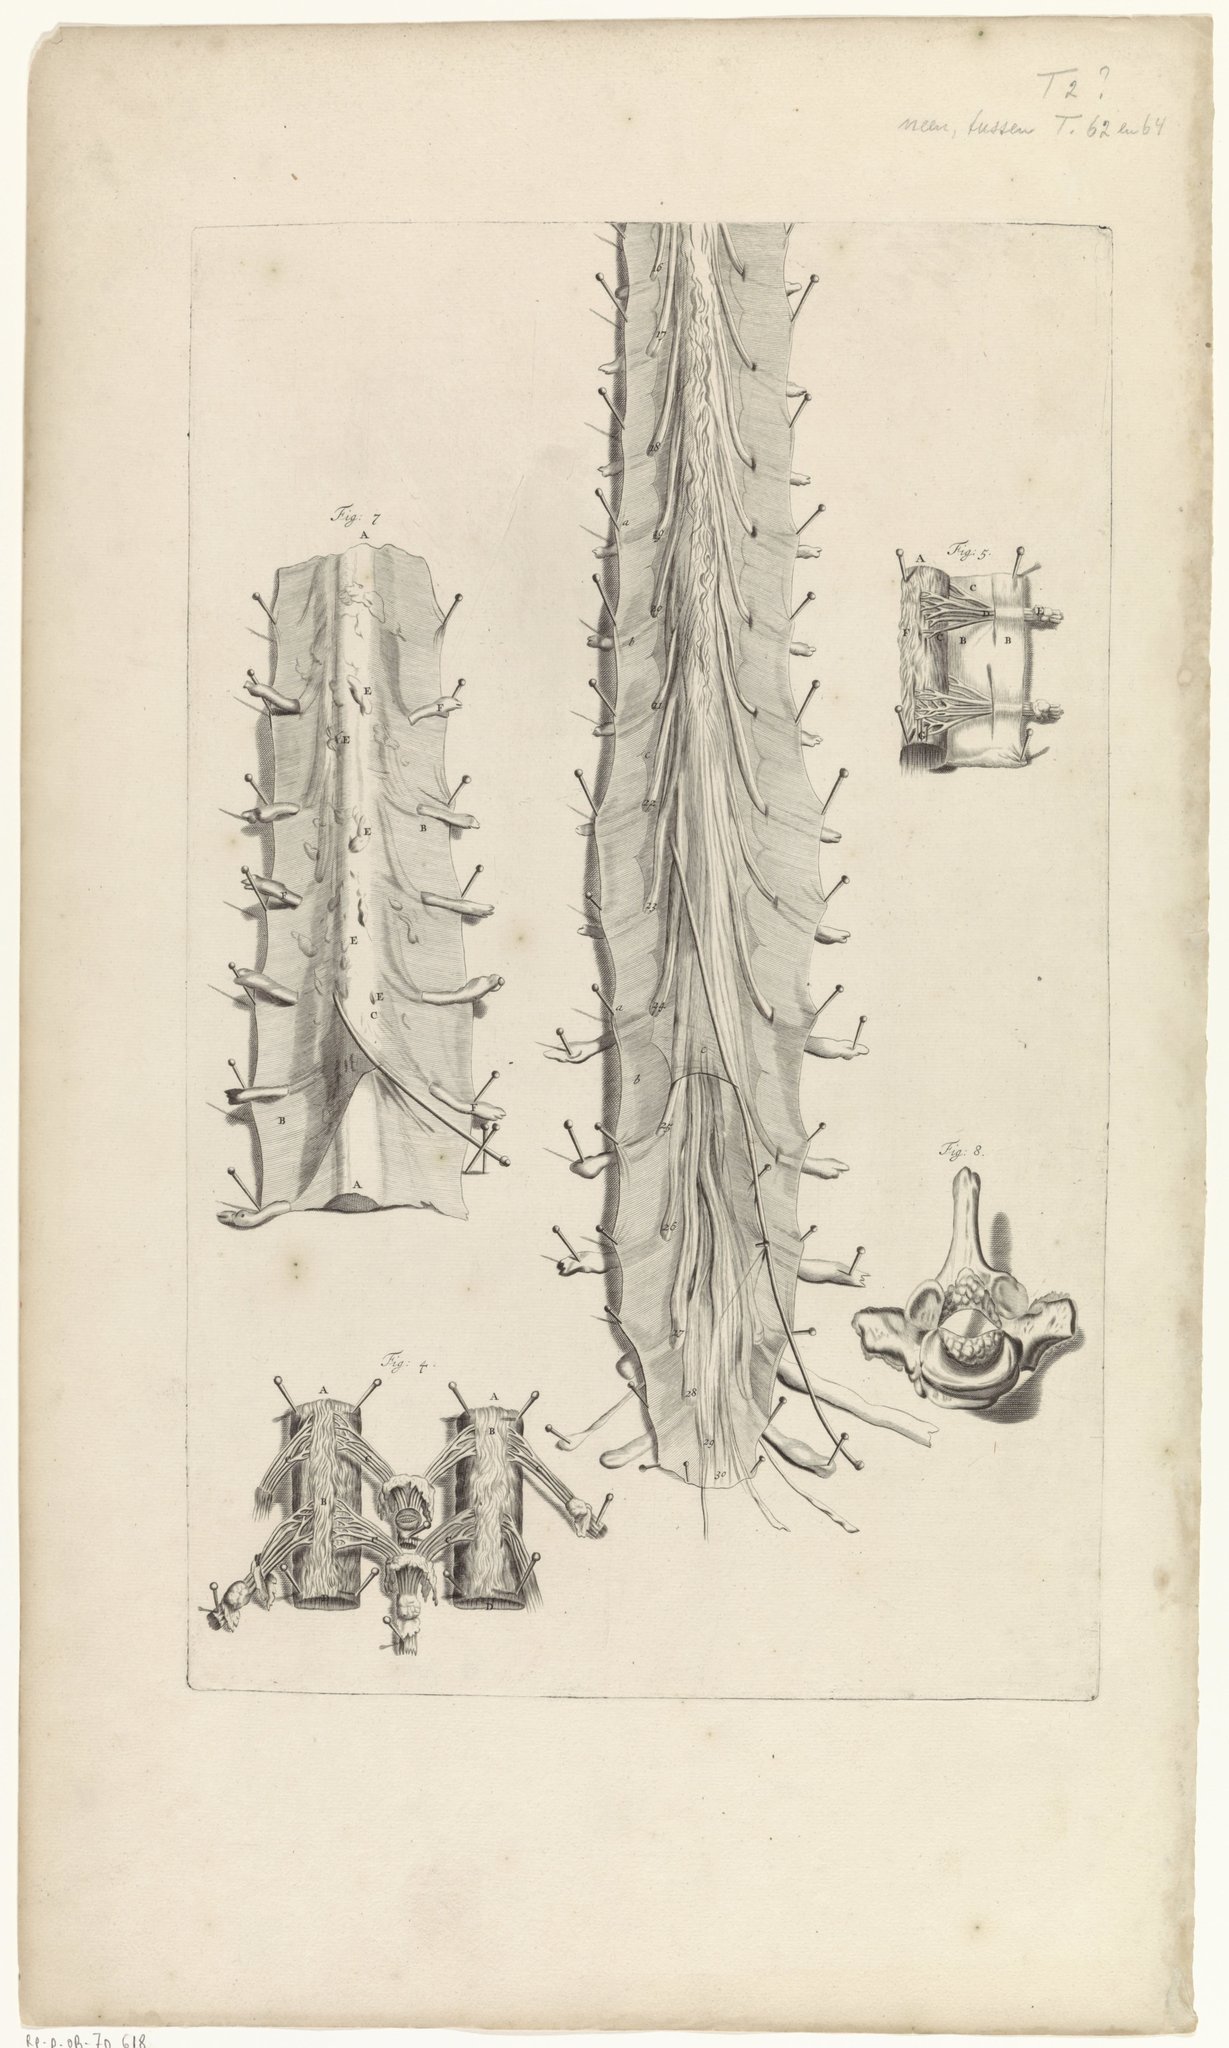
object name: book illustration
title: Anatomische studie van het wervelkanaal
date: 1685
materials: paper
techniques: engraving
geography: amsterdam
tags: spine, anatomical model of the nerves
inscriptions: collector's mark: Lugt 2228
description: Boekillustratie voor Bidloo, Godefridus. Anatomia humani corporis centum & quinque tabulis, per art. G. de Lairesse ad vivum delineatis, de monstrata, veterum recentiorumque inventis explicata plurimisque, hactenus non detectis, illustrata. Amsterdam: Weduwe Joannes van Someren, Hendrick Boom en erven Dirk Boom, 1685.